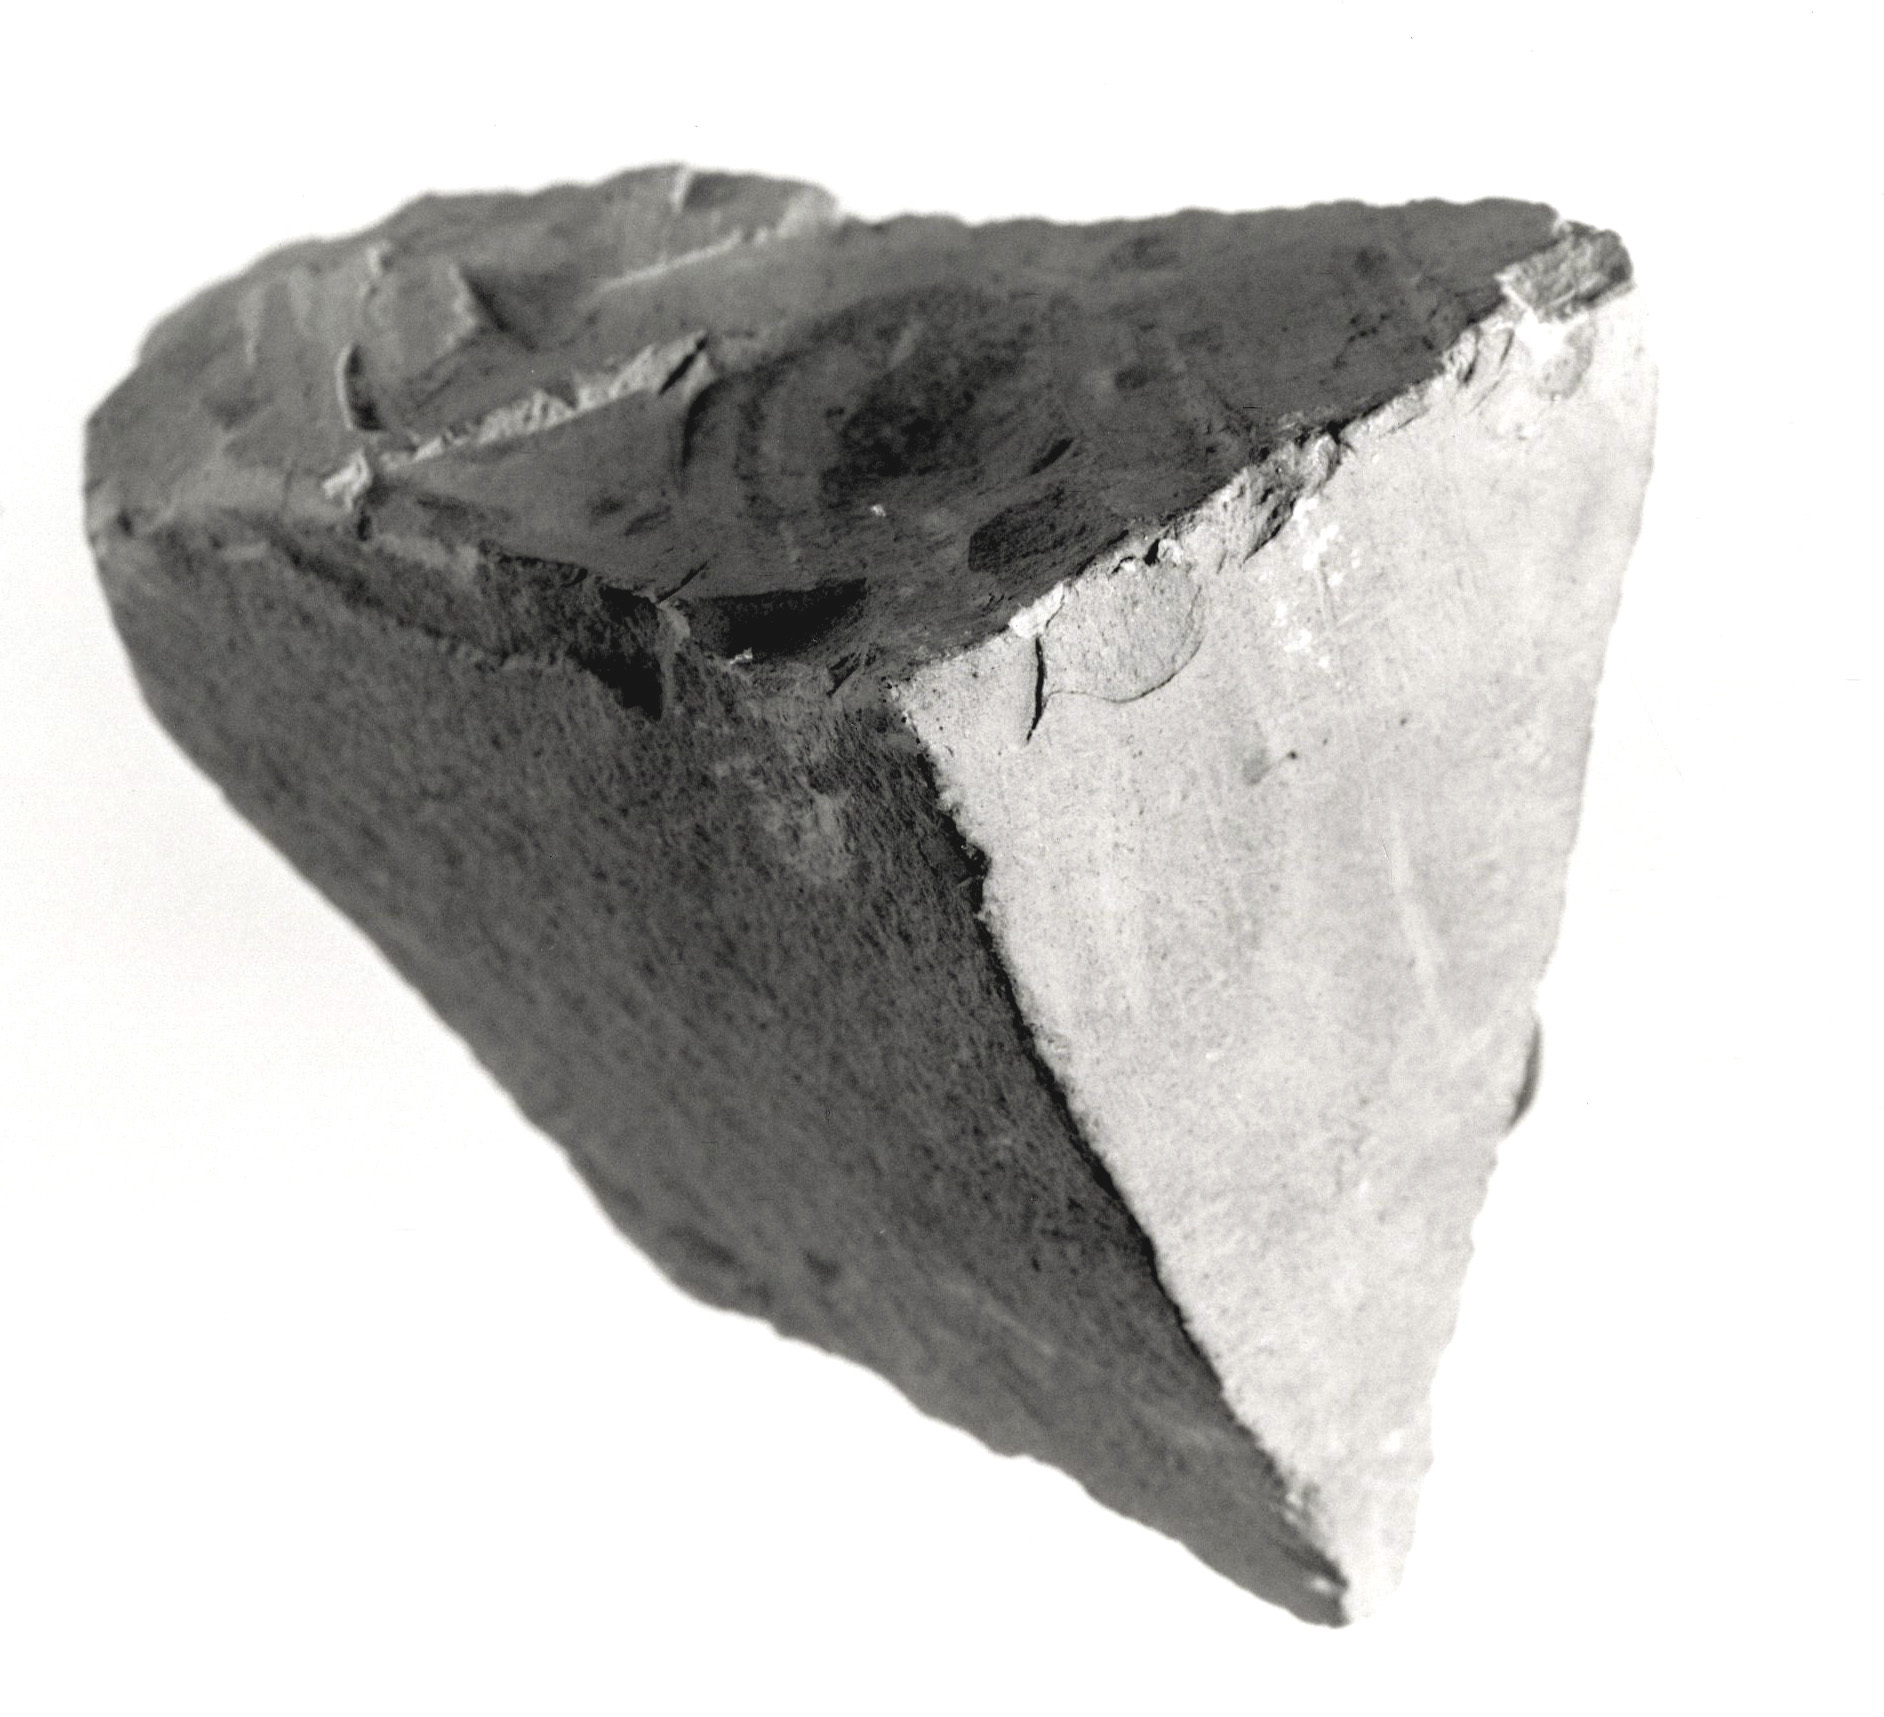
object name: relief, tomb of nespekashuty, wall casing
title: Wall casing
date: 664-610 BCE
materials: limestone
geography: egypt